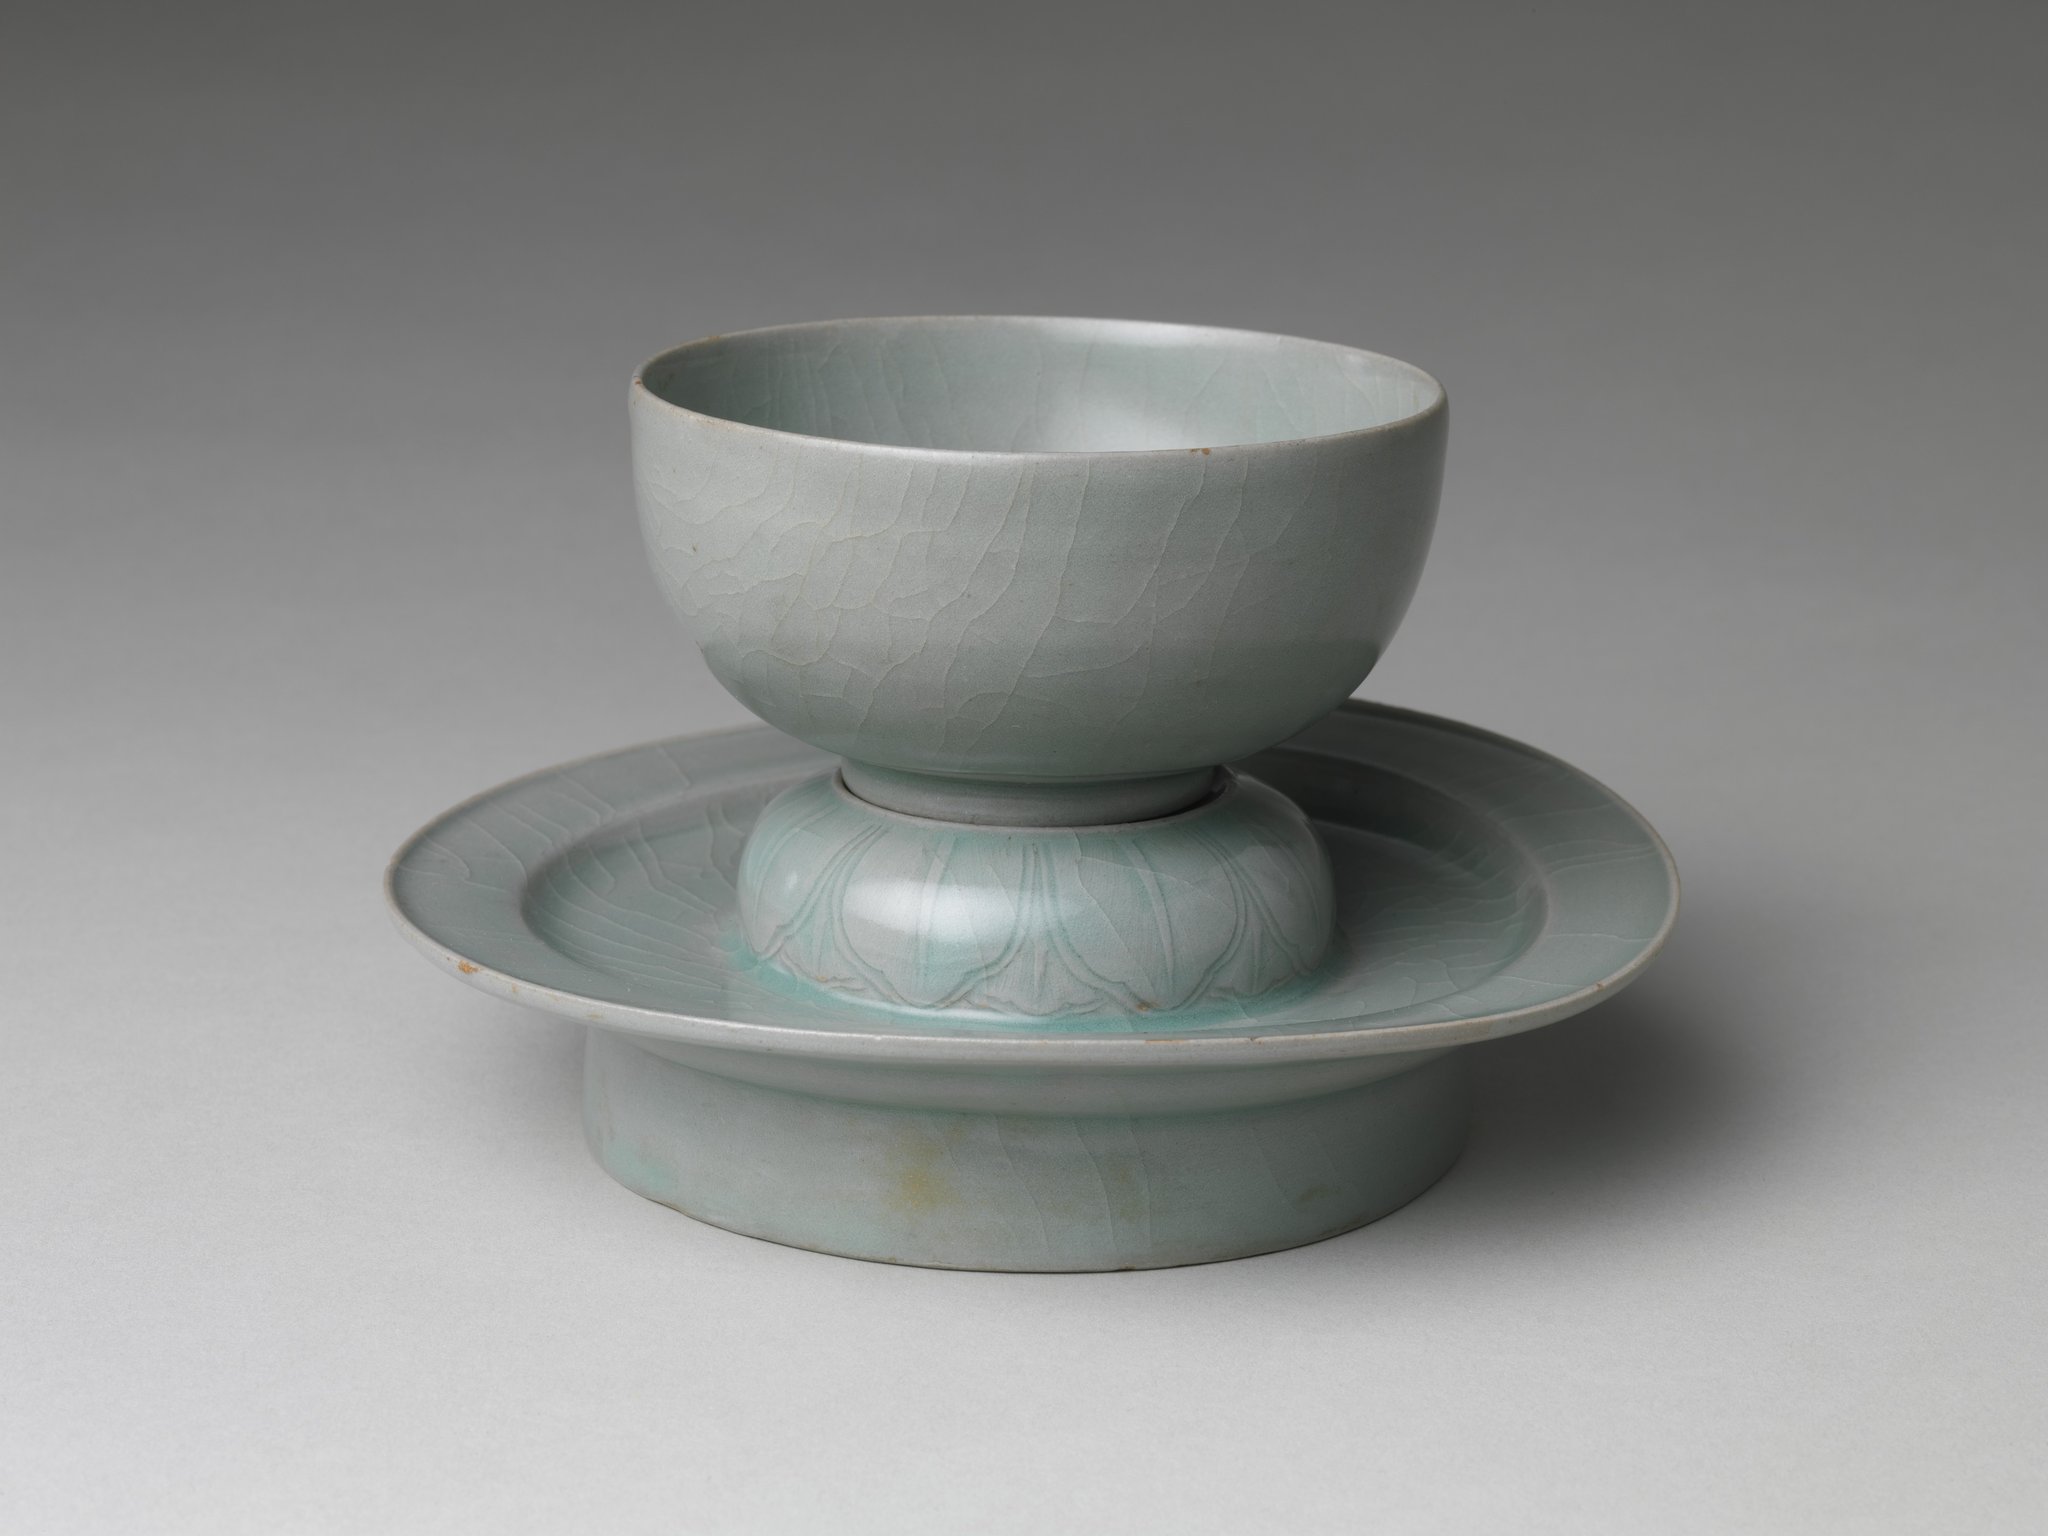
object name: cup stand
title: Cup and stand decorated with lotus seeds and petals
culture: korean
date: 1101-1150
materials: ceramic glaze, glaze, stoneware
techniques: incising